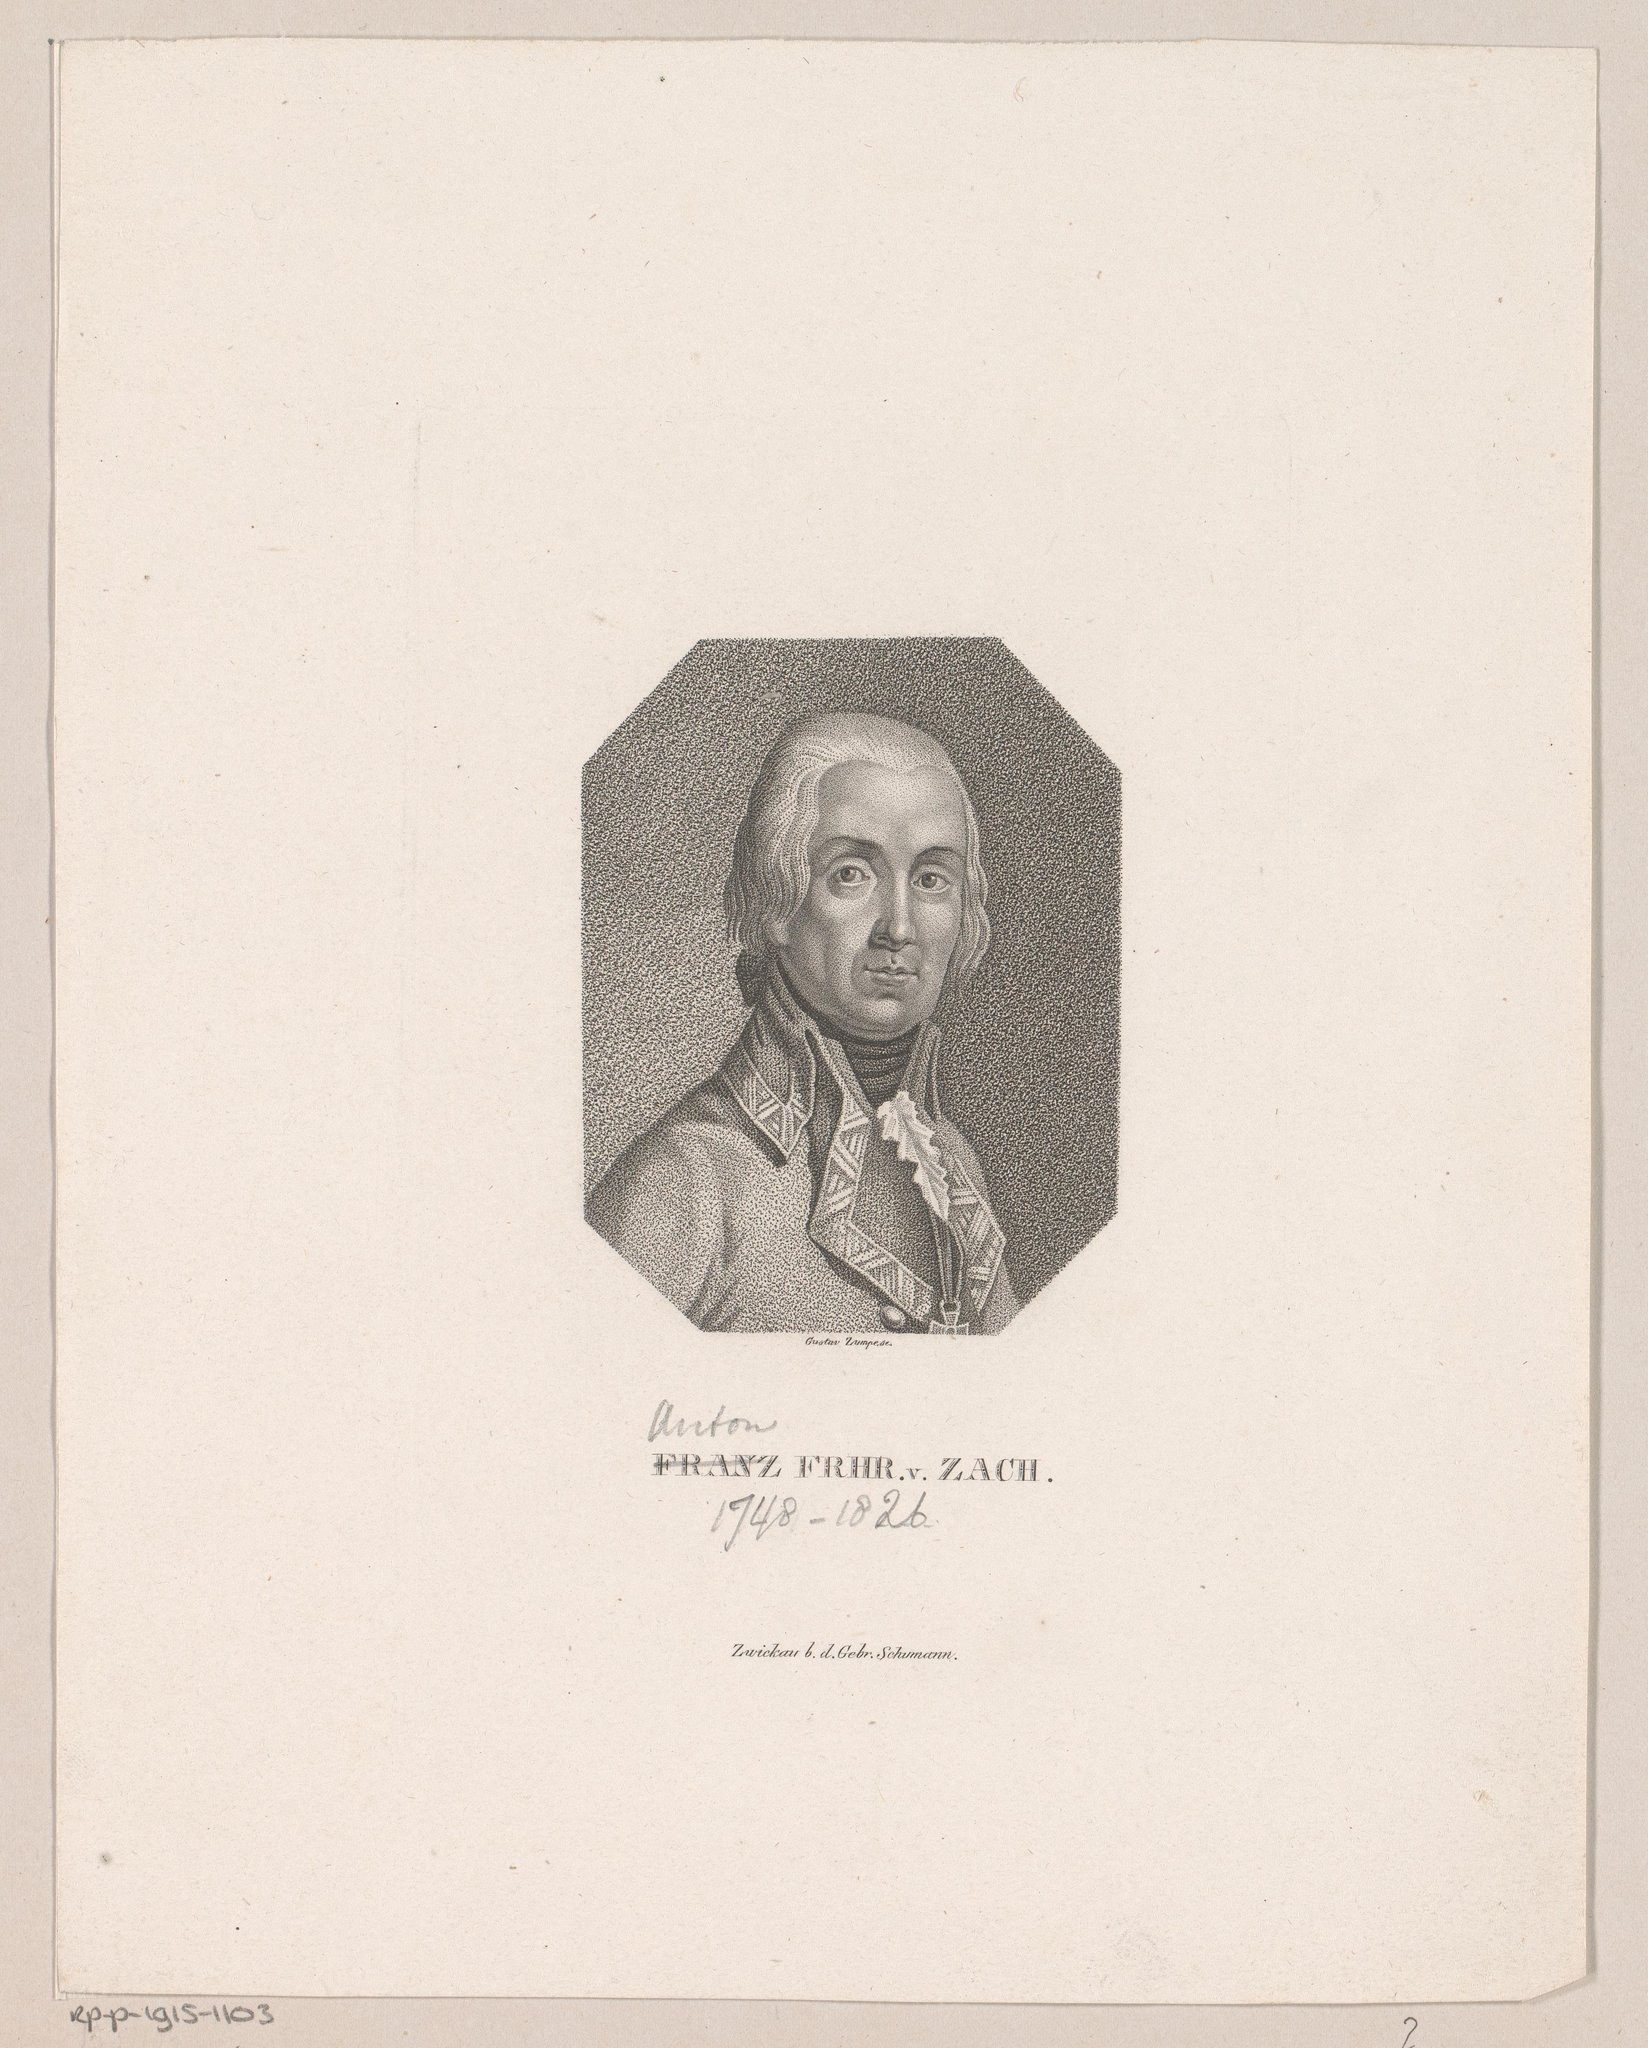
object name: book illustration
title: Portretten van beroemde mensen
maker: gustav zumpe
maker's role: print maker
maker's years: 1793-1854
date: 1818-1832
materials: paper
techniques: etching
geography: germany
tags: historical persons, officer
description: Prent waarschijnlijk uit: Bildnisse der berühmtesten Menschen aller Völker und Zeiten. Zwickau en Leipzig: Gebroeders Schumann, 1818-1832.